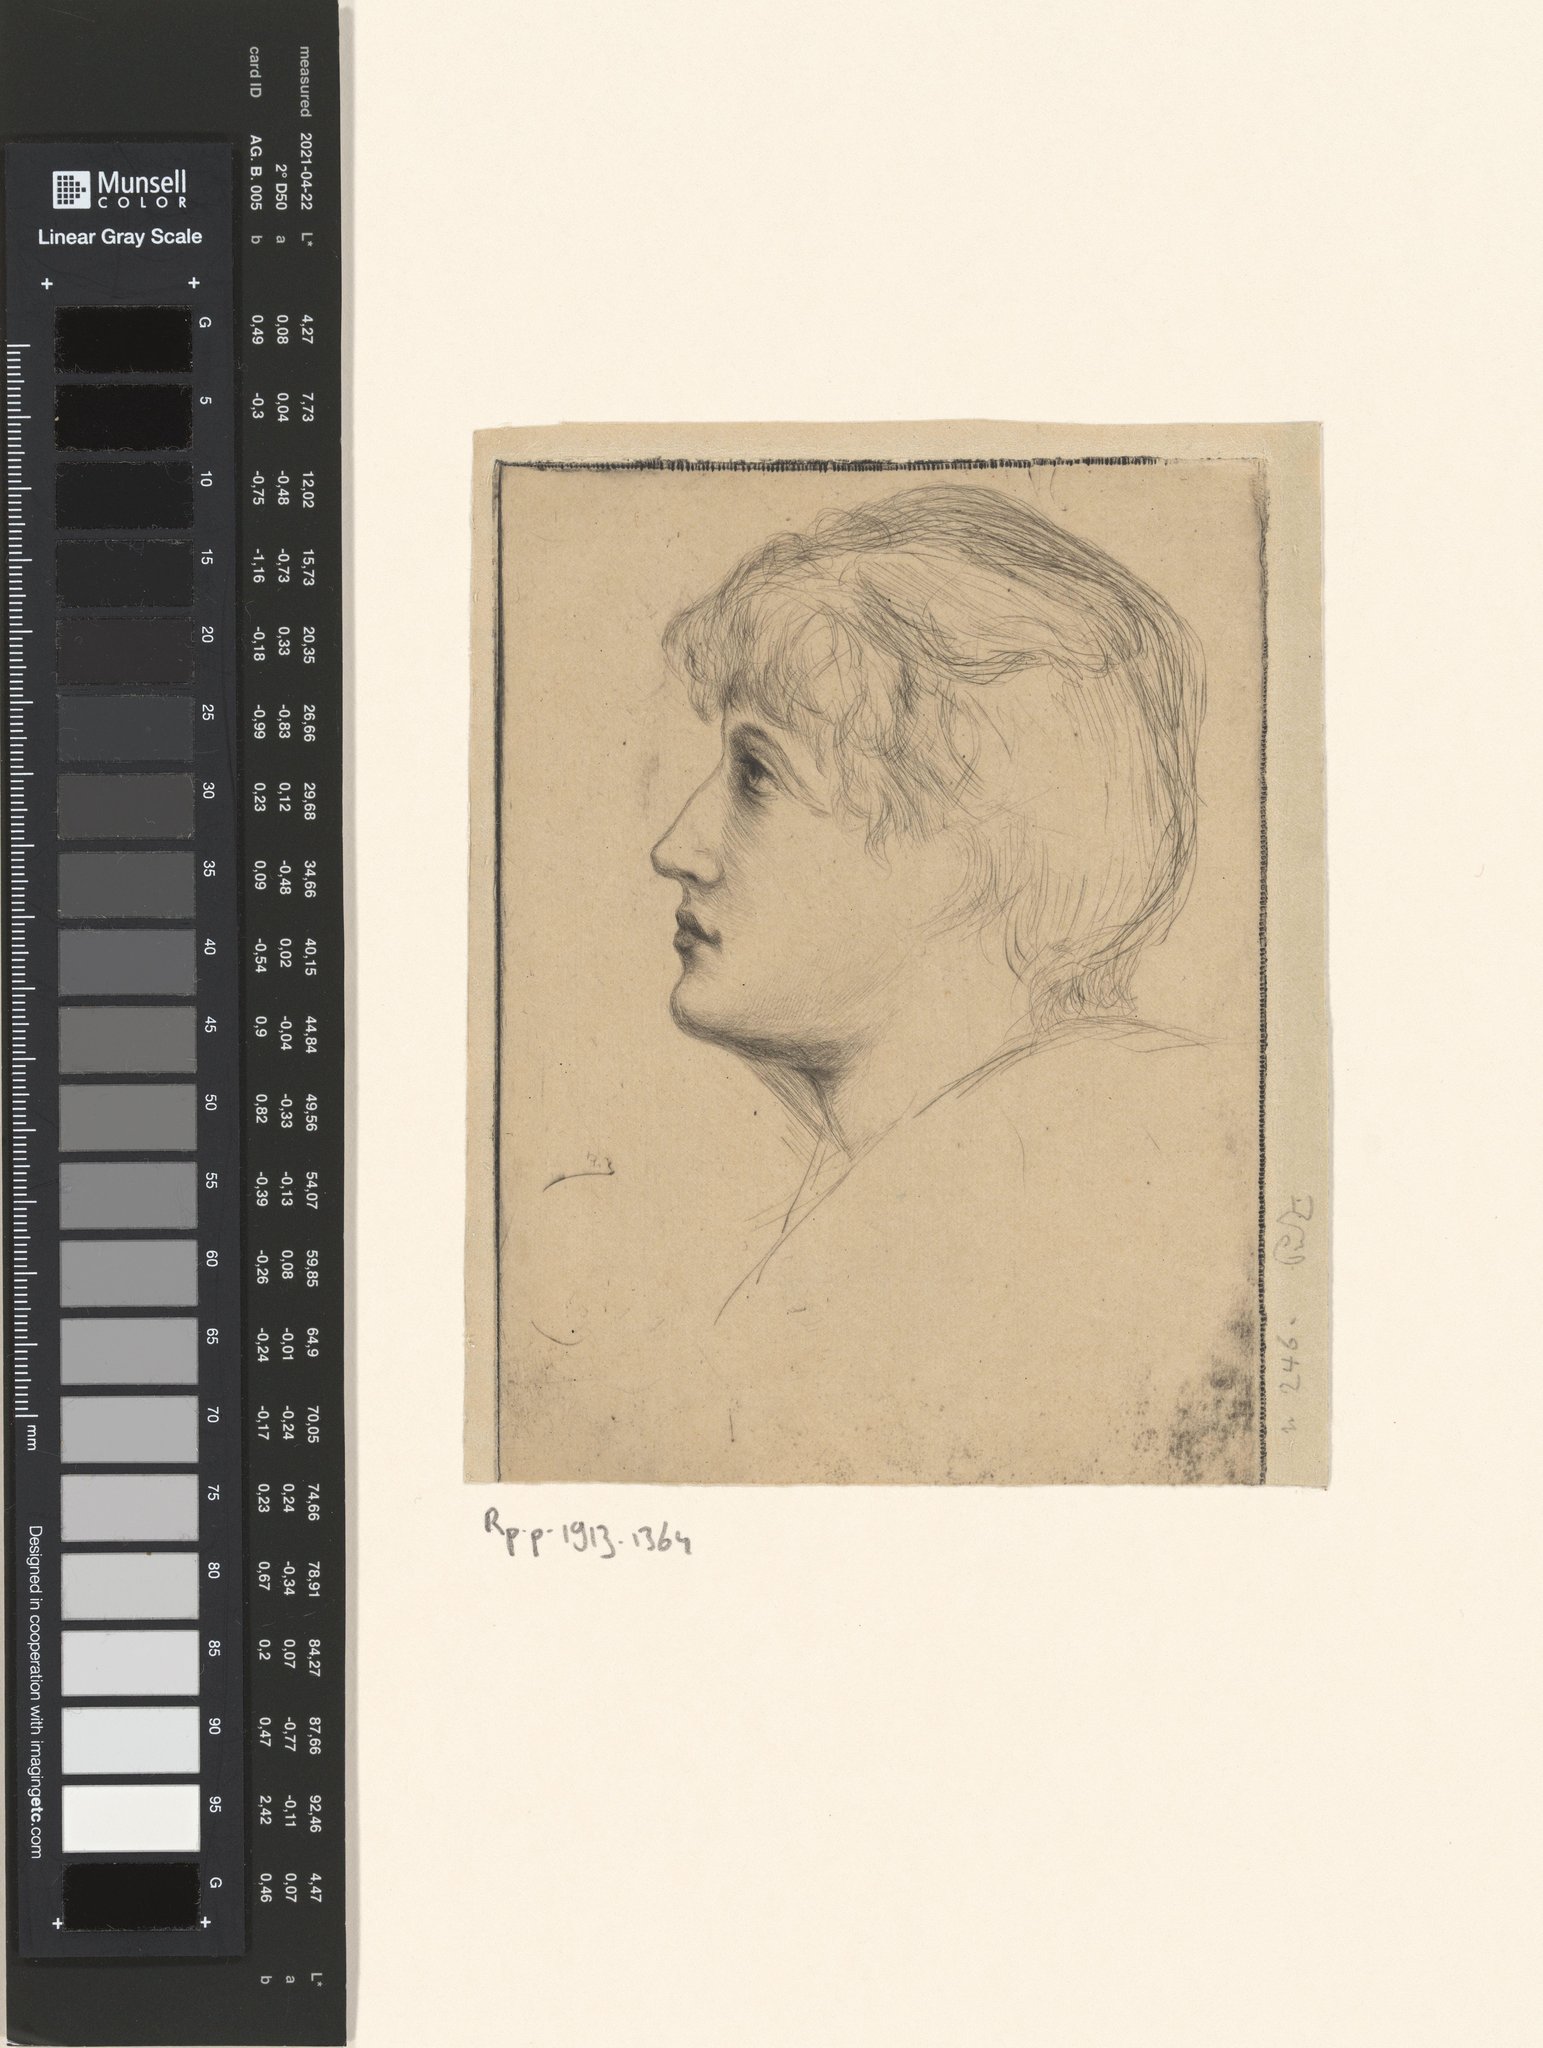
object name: print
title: Hoofd van een jonge vrouw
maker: philip zilcken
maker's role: draughtsman, painter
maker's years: 1857-1930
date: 1890-1913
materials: paper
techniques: drypoint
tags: adolescent, young woman, maiden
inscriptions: collector's mark: Lugt 2233